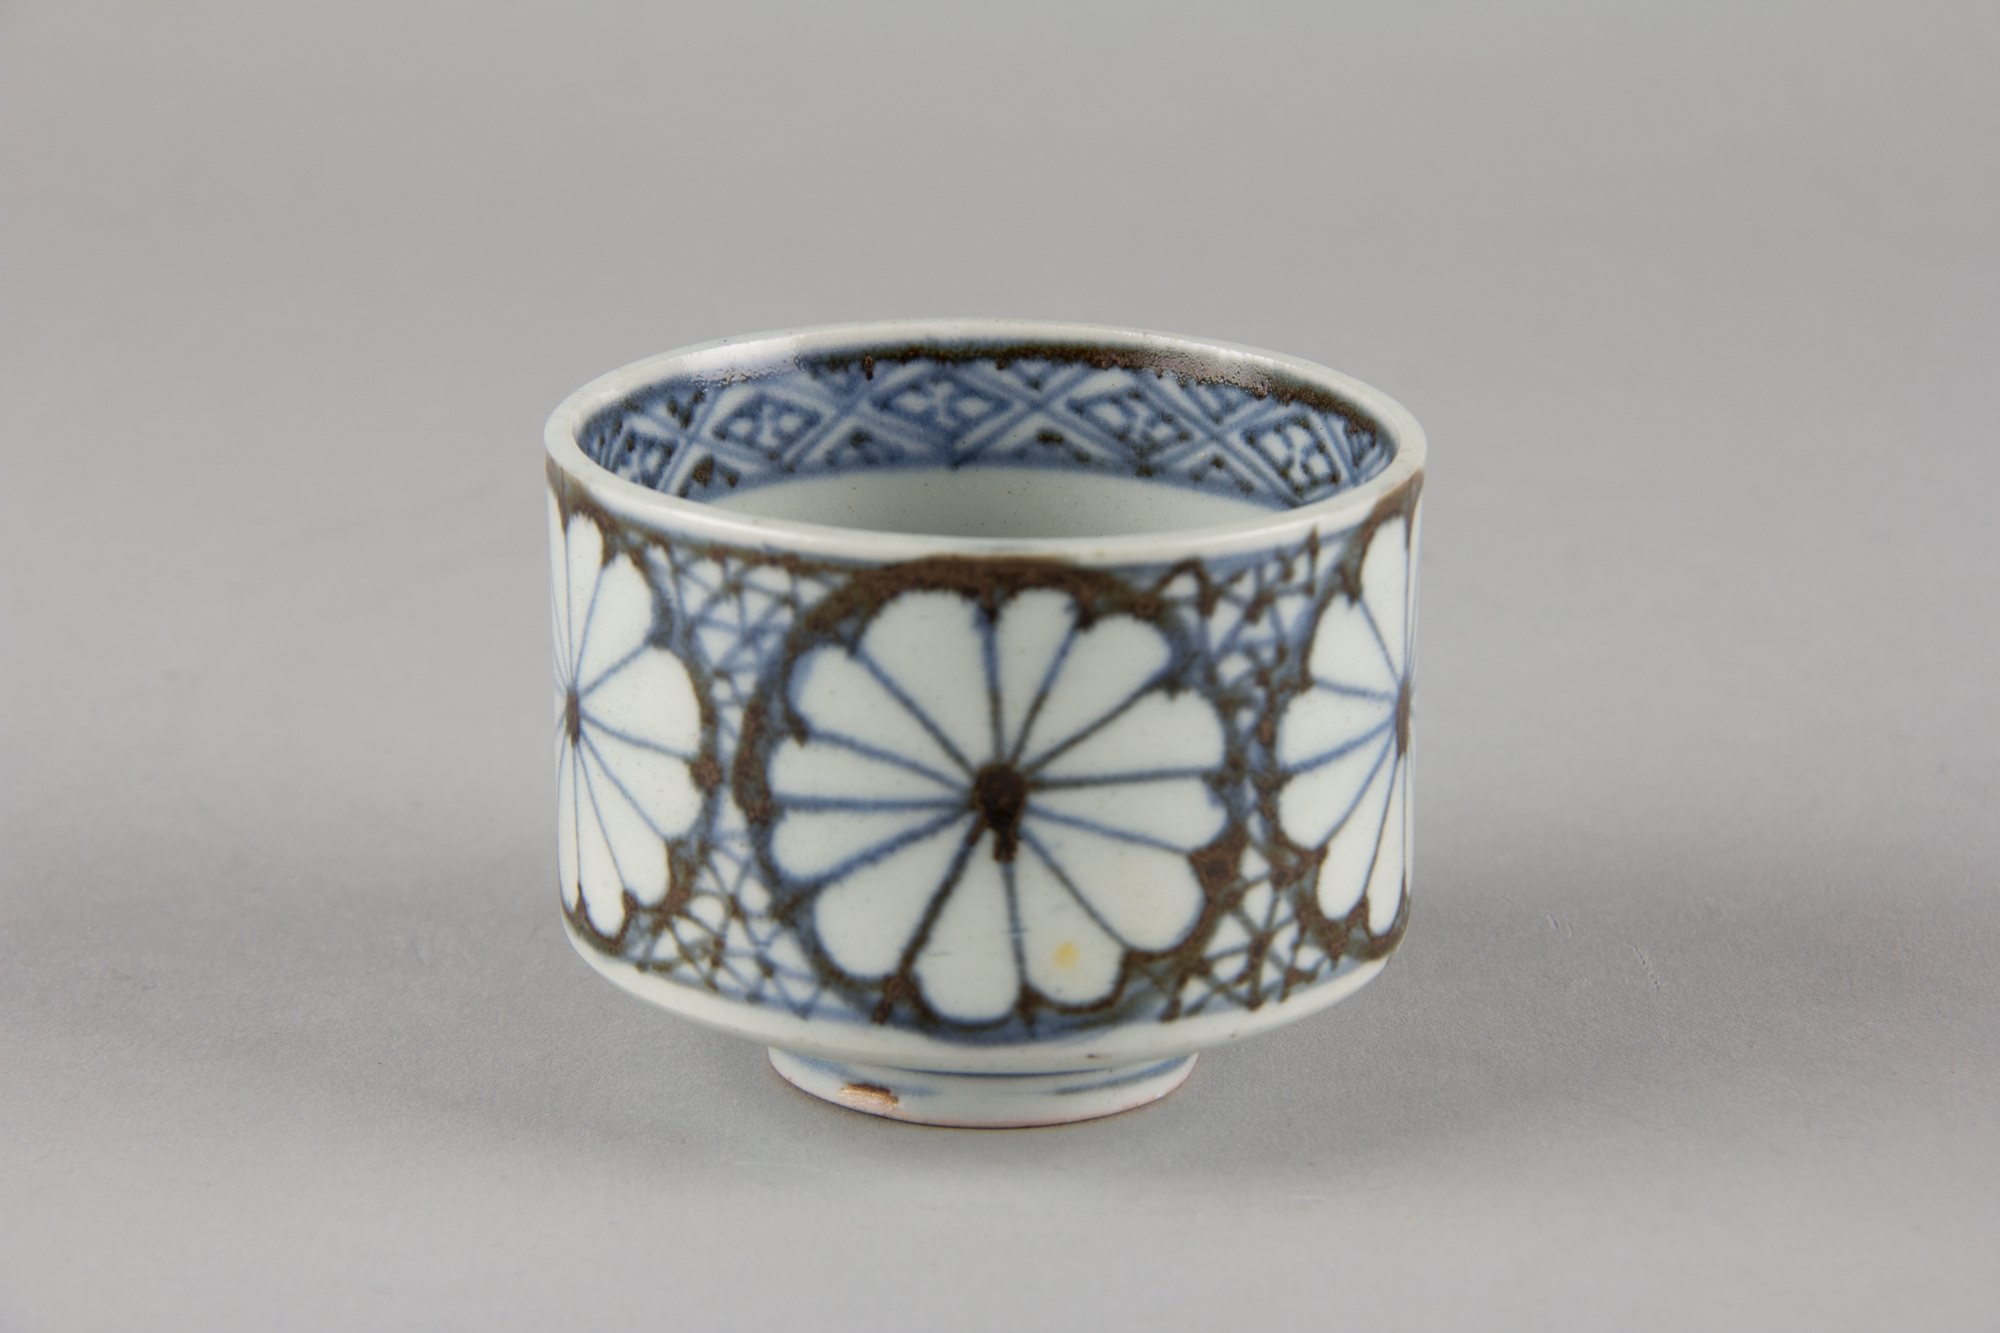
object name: soba cup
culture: japanese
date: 1801-1900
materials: cobalt, porcelain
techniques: painting, underglaze